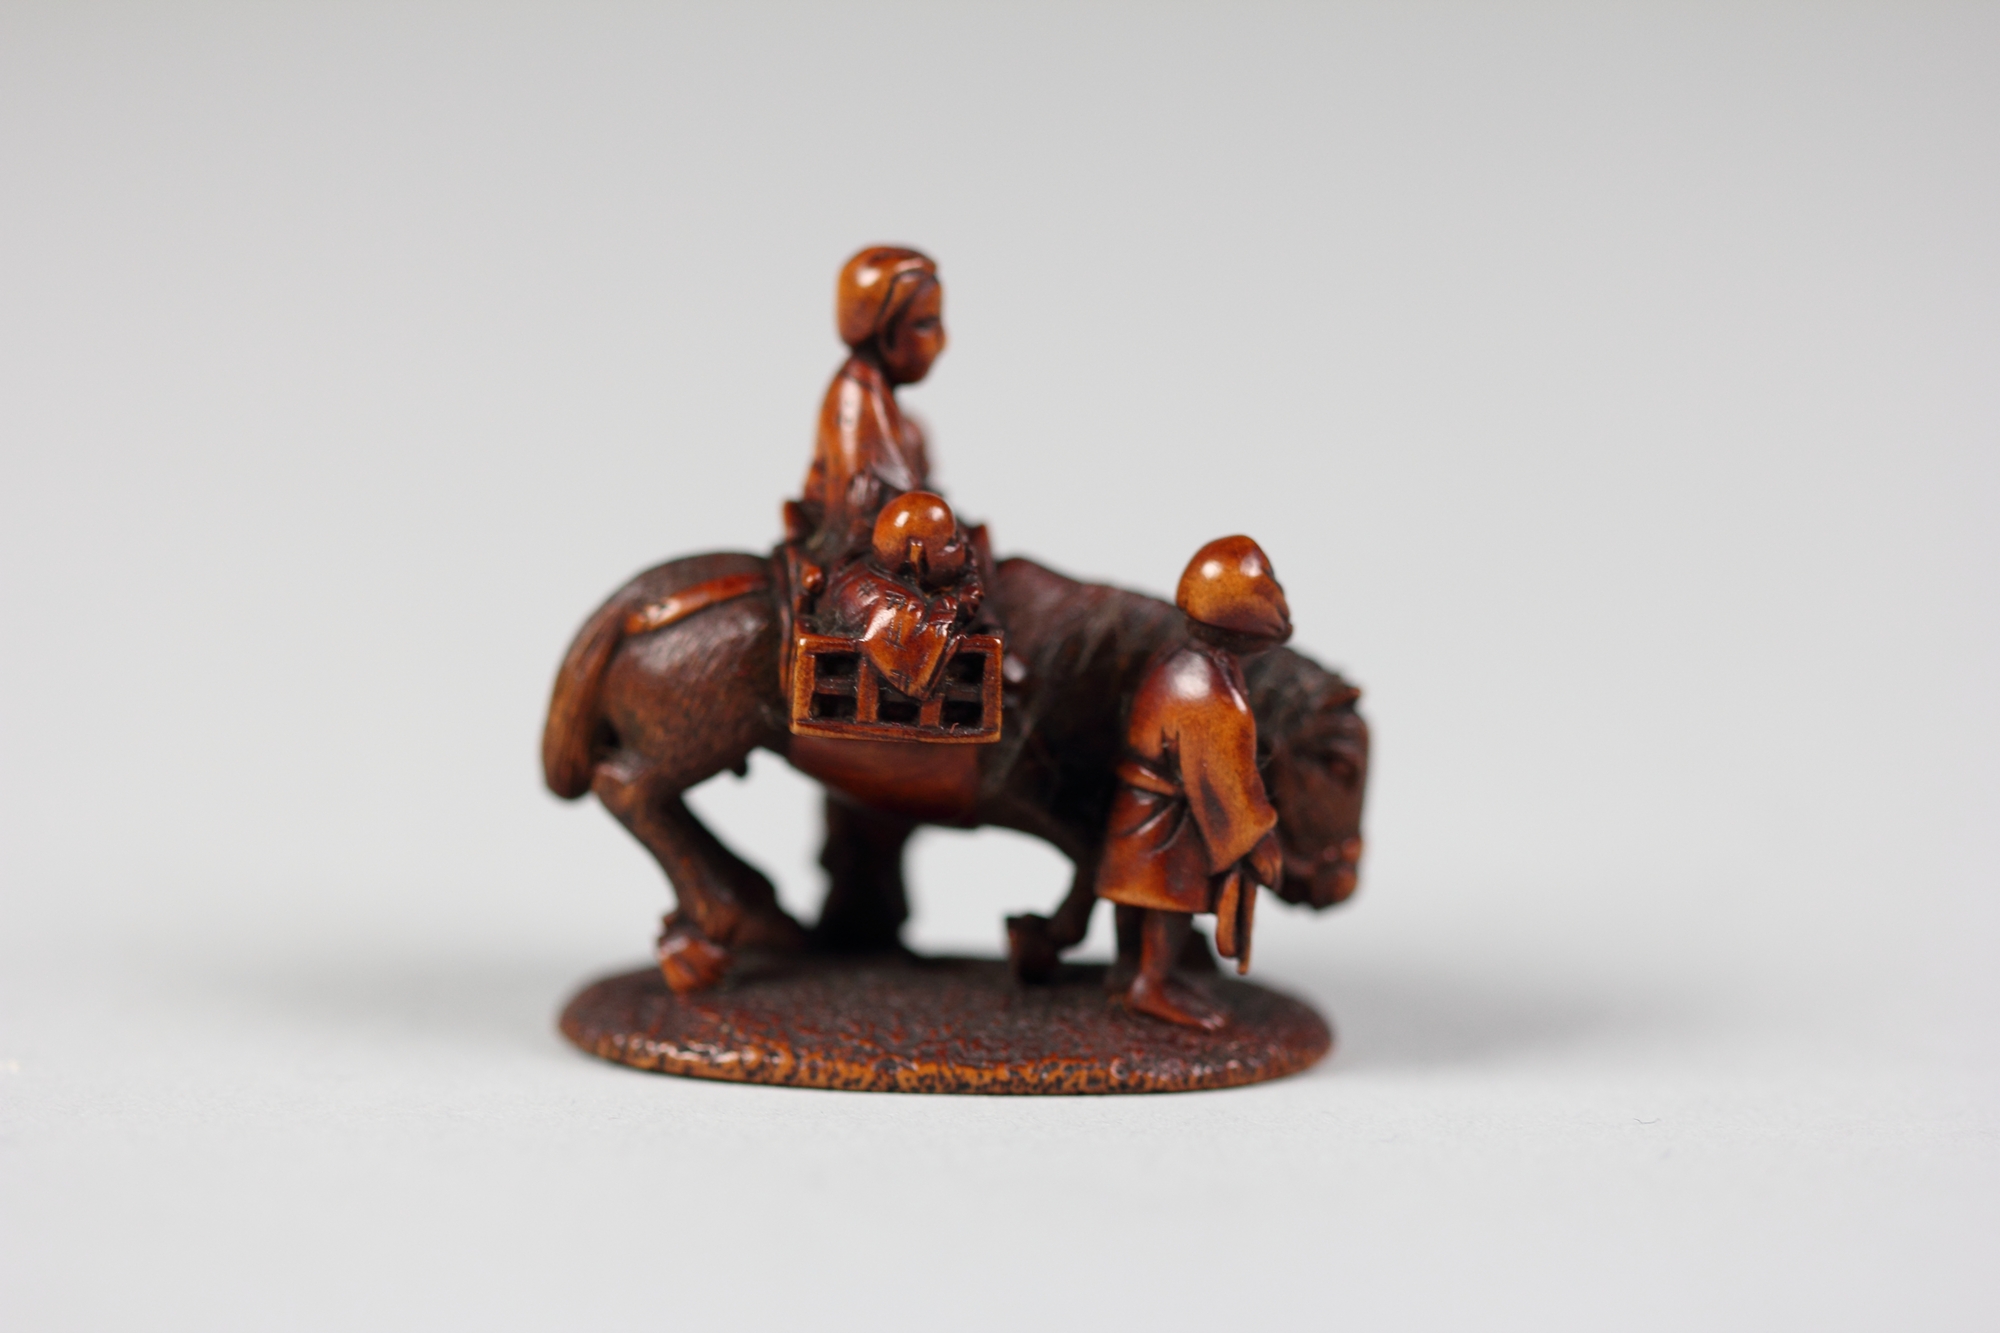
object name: netsuke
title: Netsuke of Figures with Horse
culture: japanese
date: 1801-1900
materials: wood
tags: men,horses